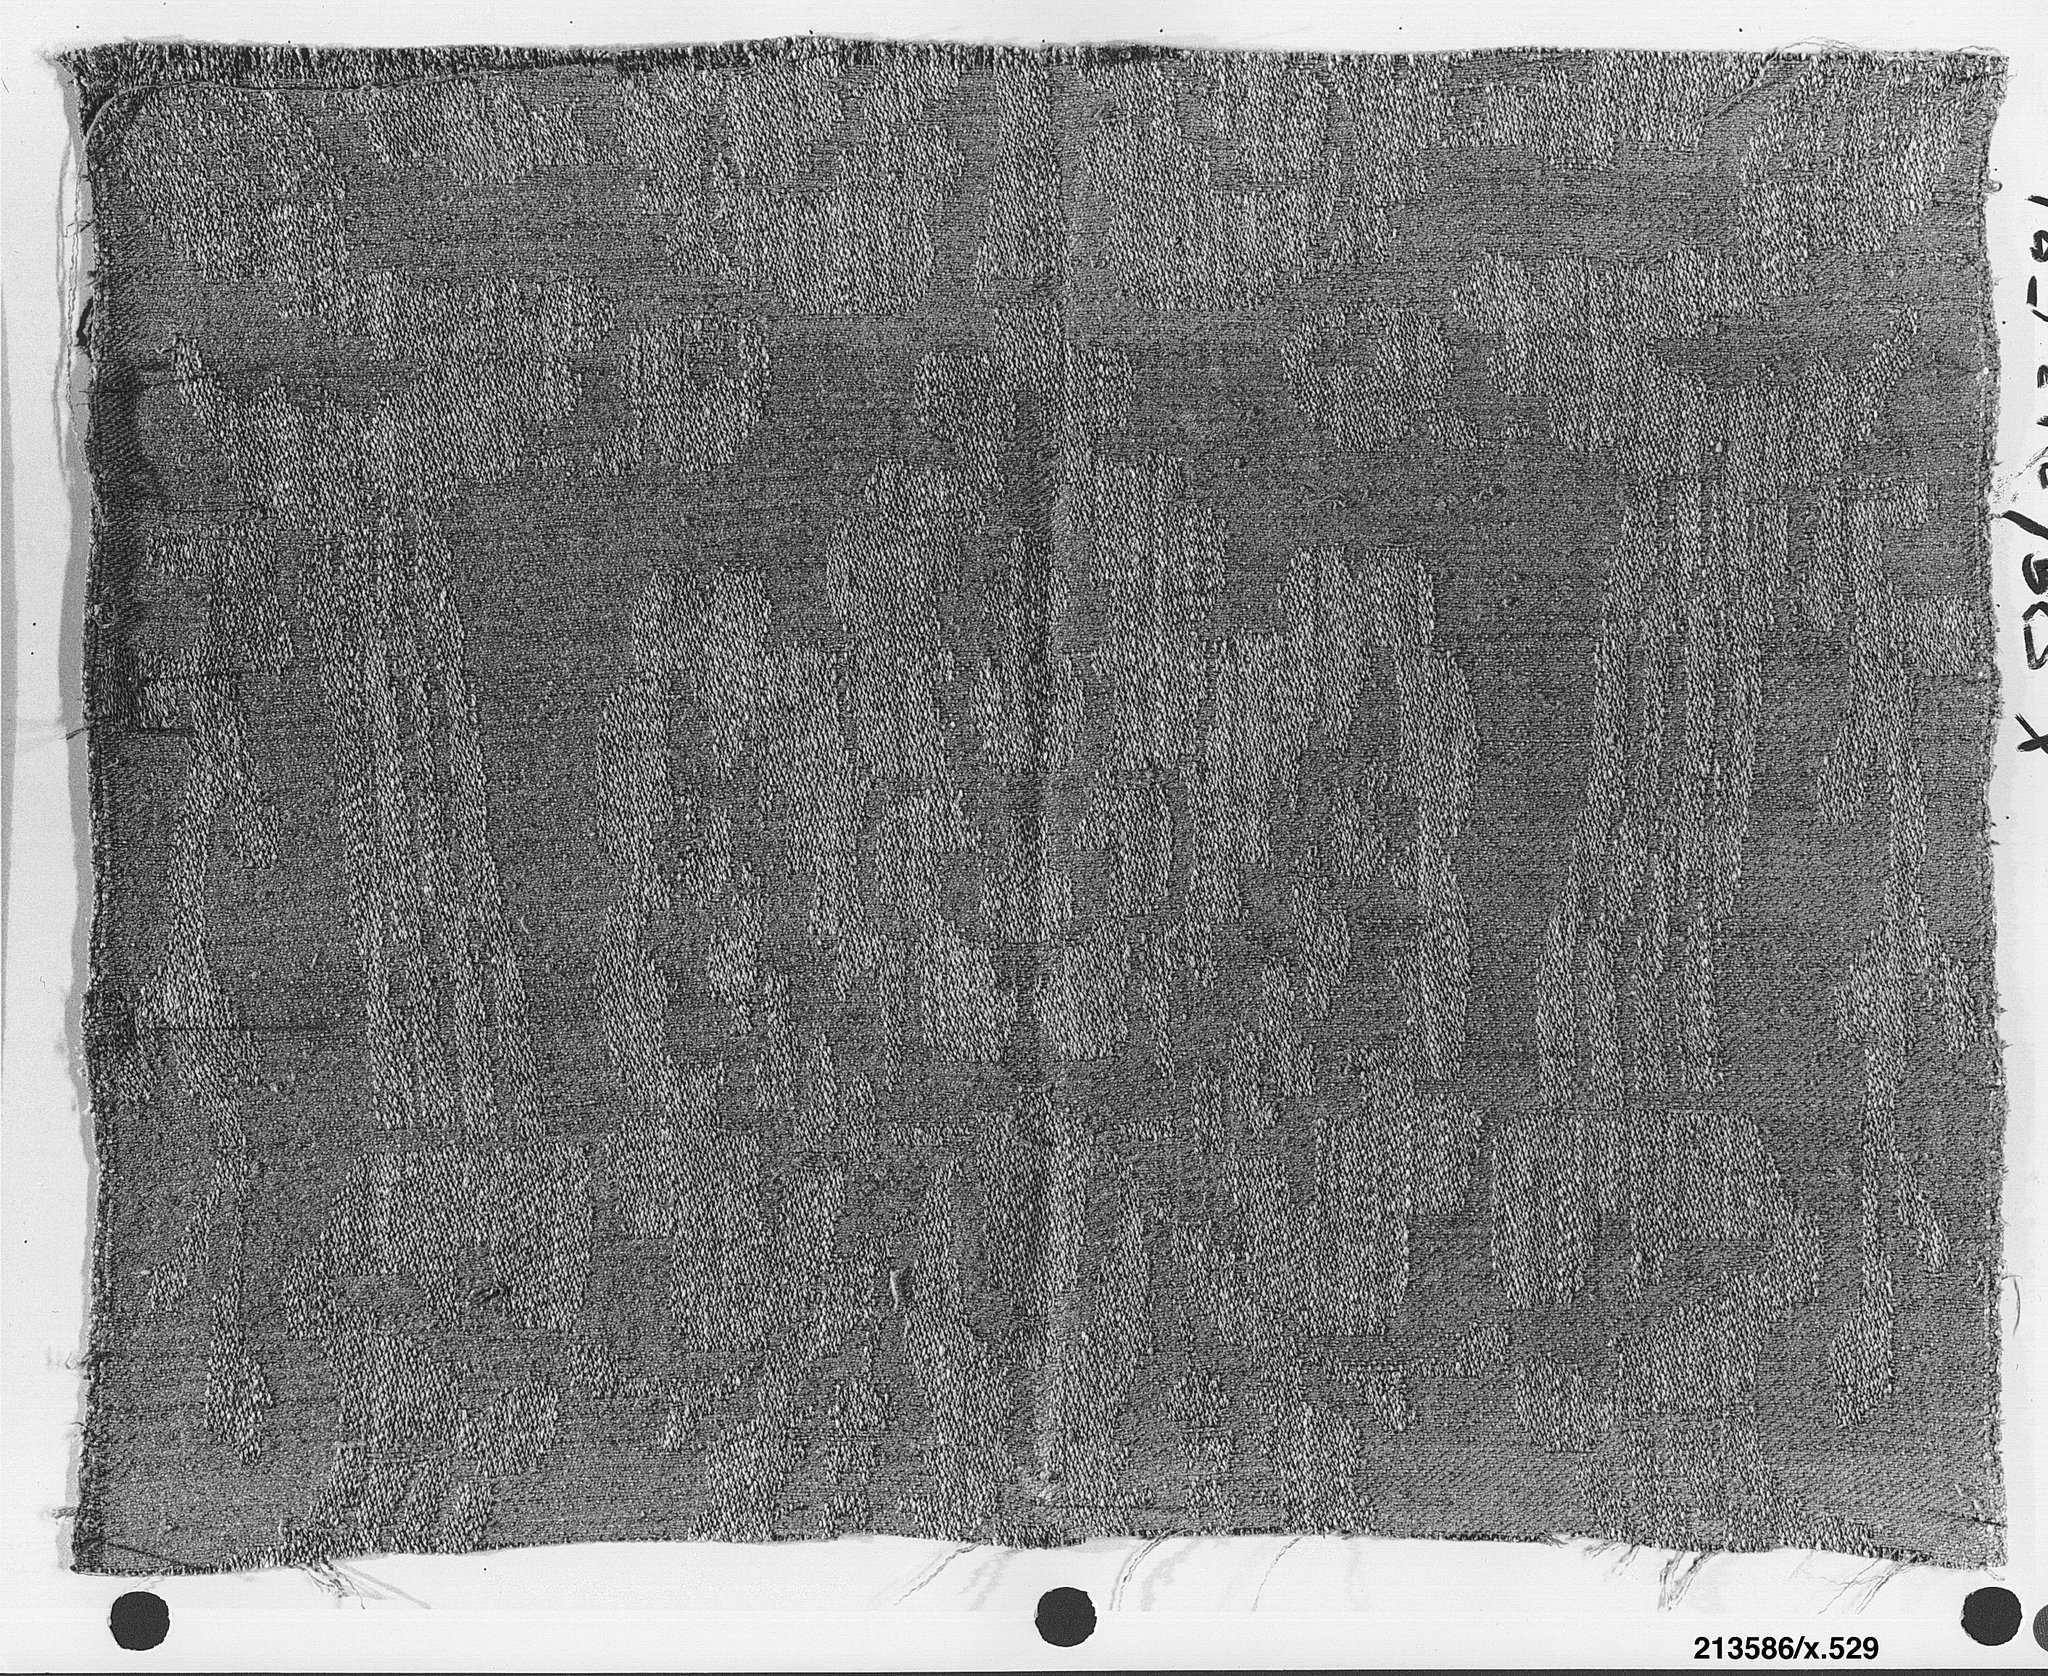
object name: panel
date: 1701-1800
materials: silk